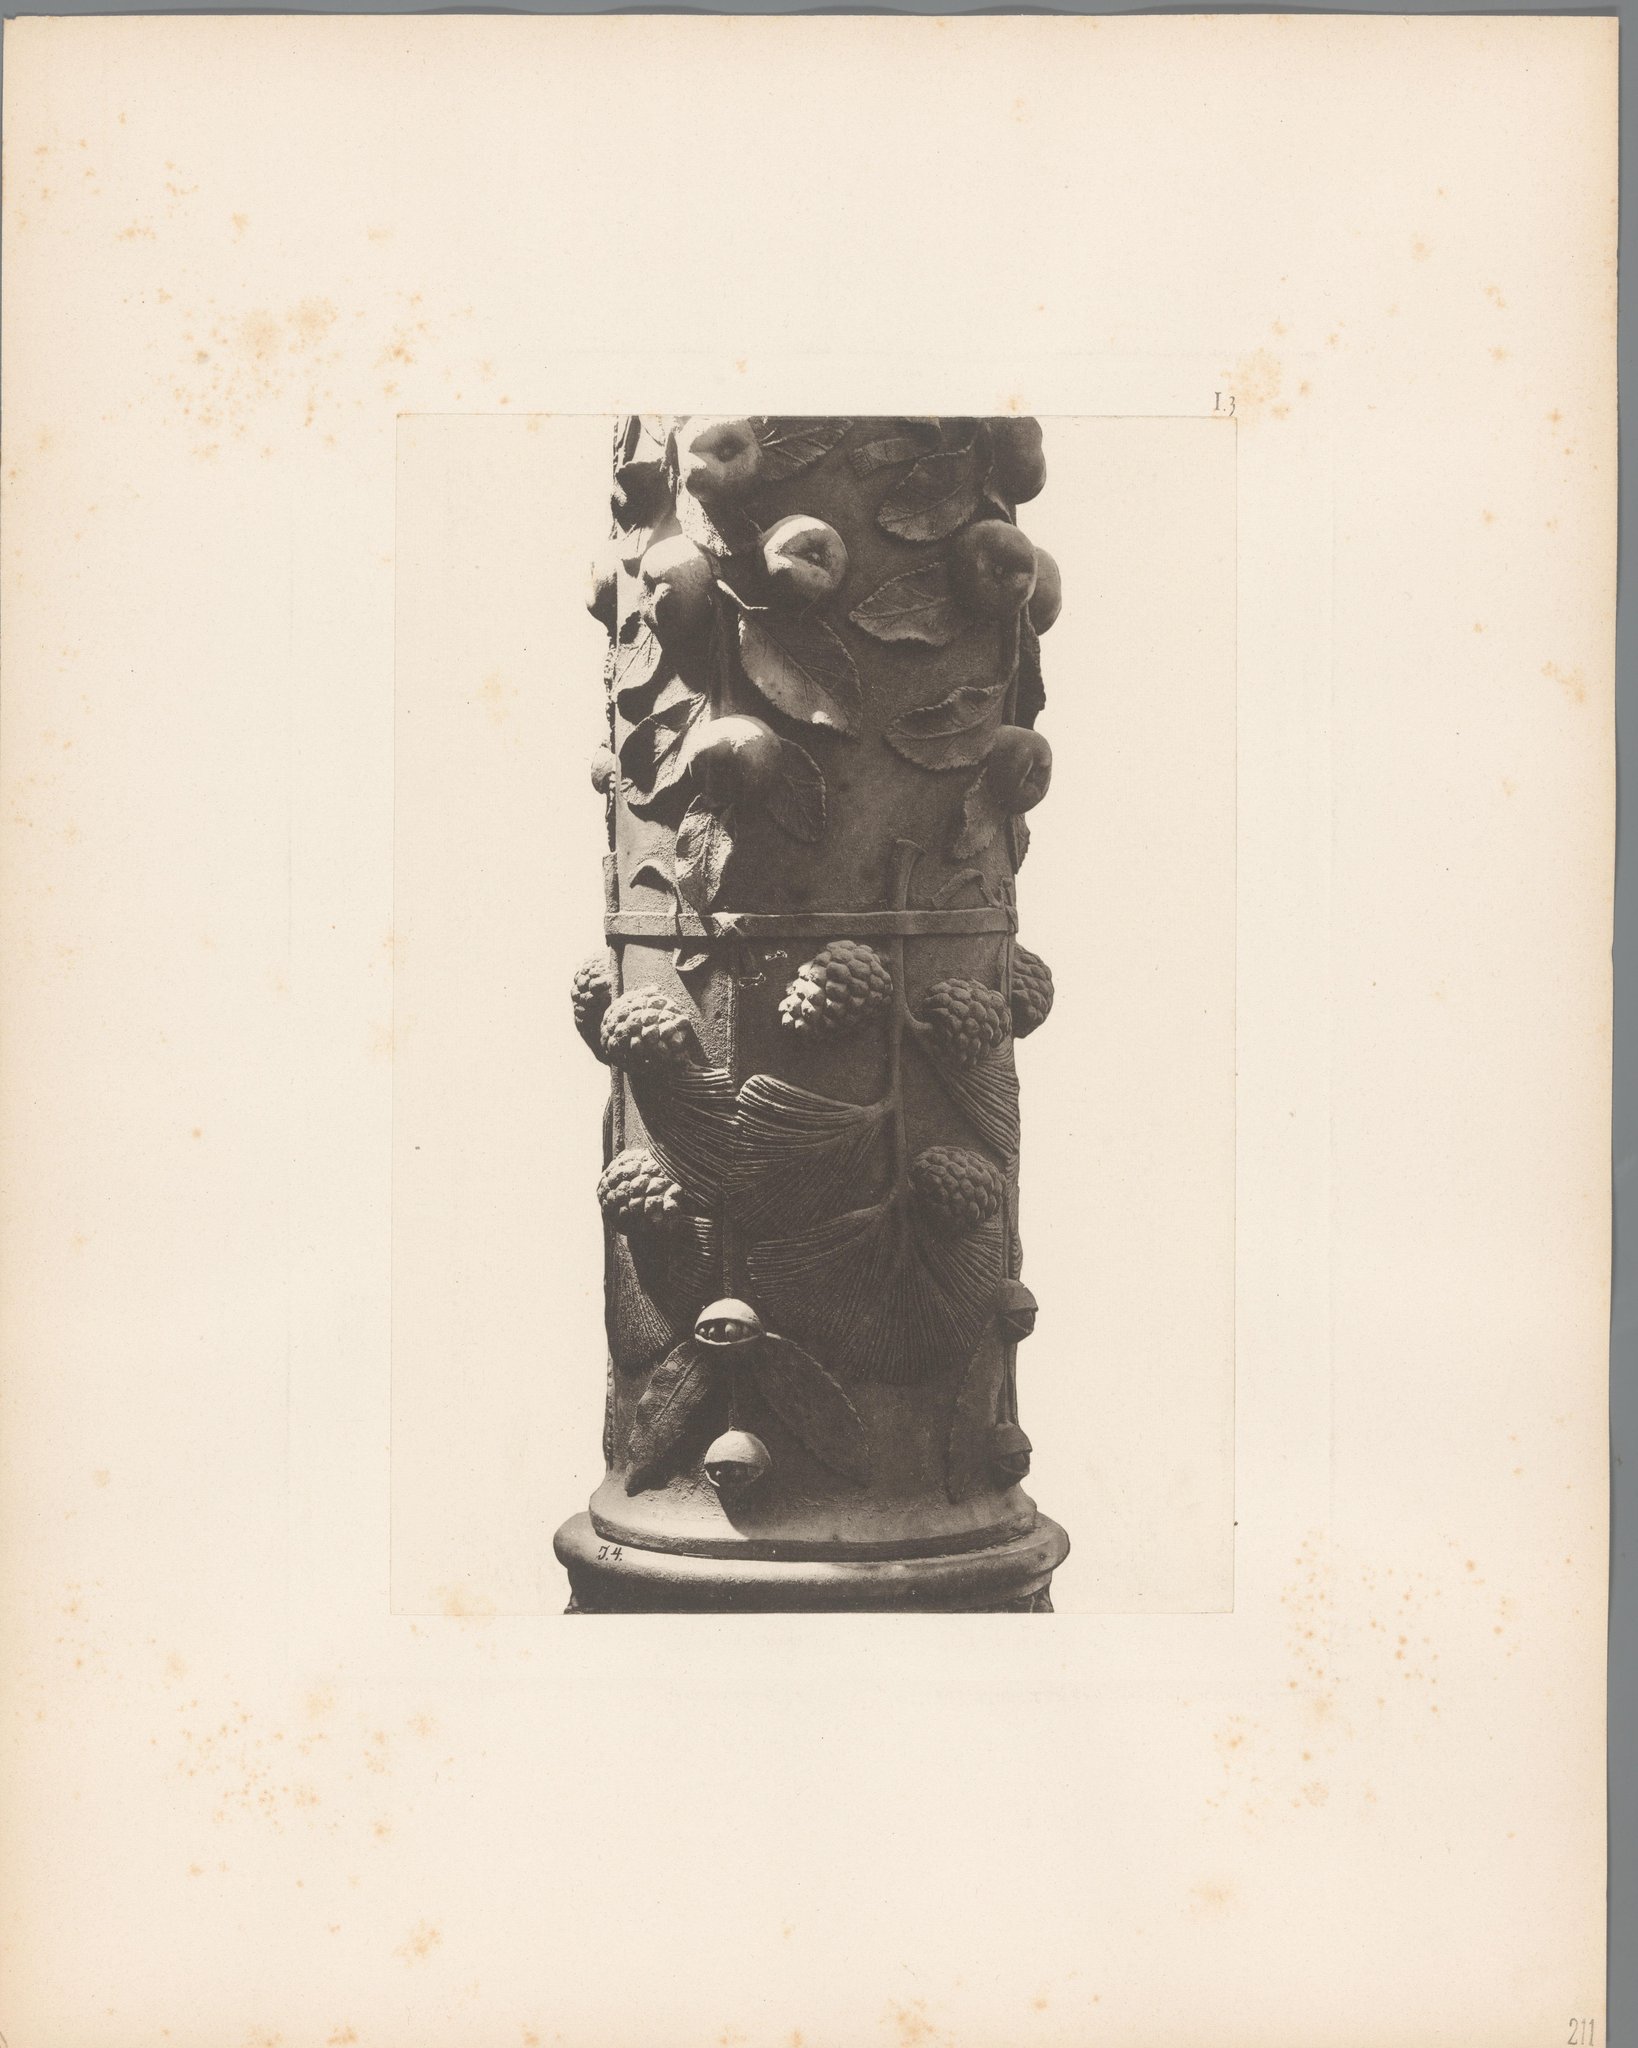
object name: photomechanical print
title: Deel van een gedecoreerde zuil van de San Marco in Venetië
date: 1880-1885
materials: paper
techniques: photograph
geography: st. mark's basilica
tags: column, pillar ~ architecture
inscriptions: number: ‘I.3’, number: ‘J.4.’, number: ‘211’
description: Deze prent maakt deel uit van een omslag met 79 prenten op 53 bladen en 2 tekstbladen.